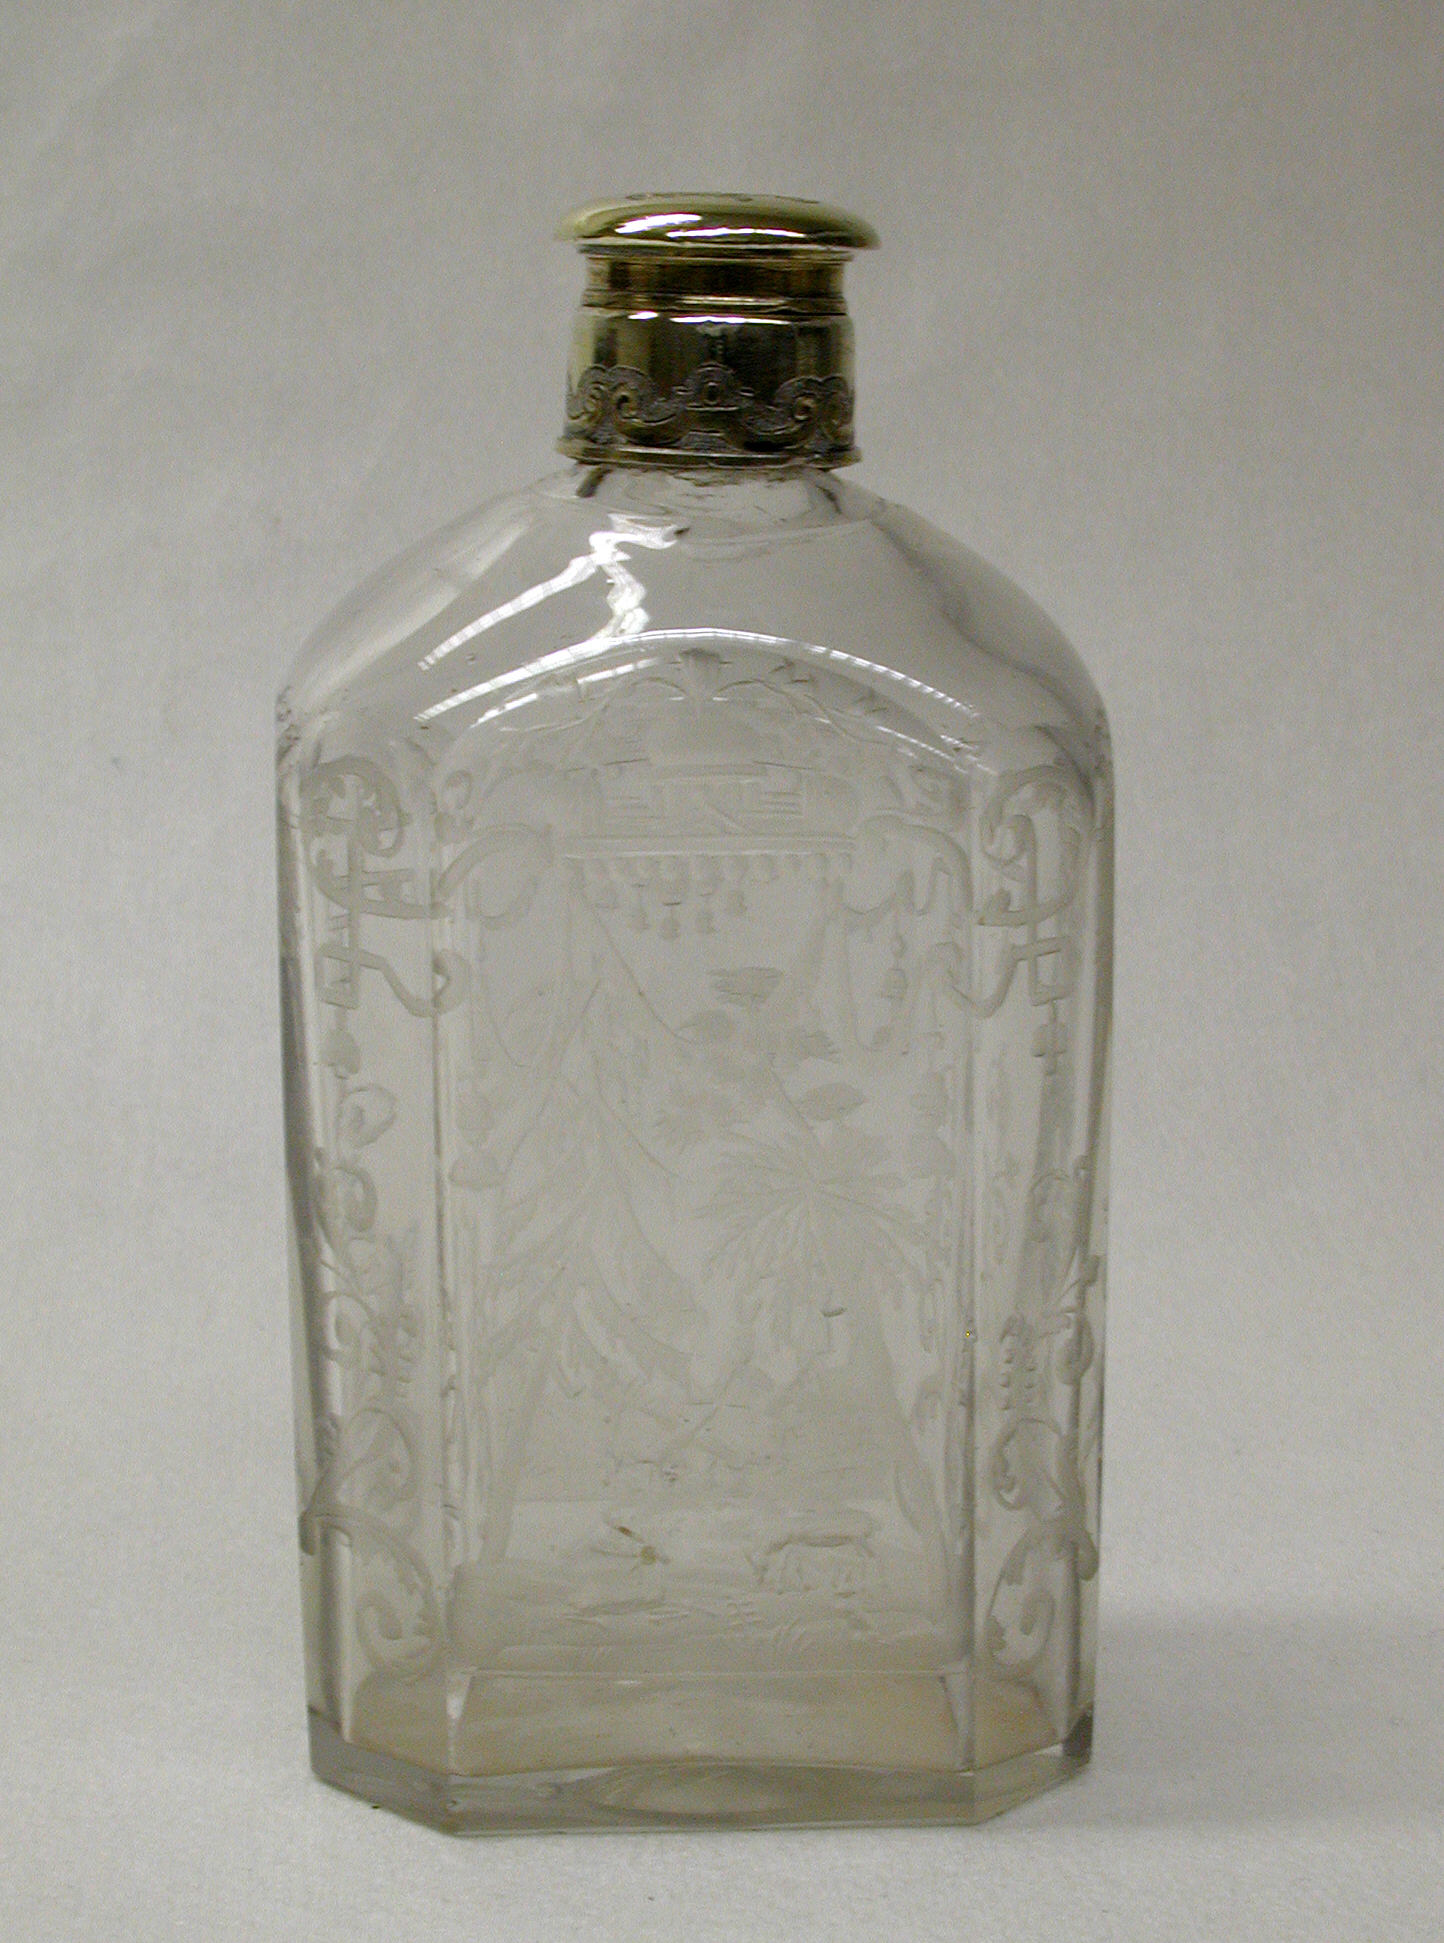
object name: flask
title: Flask (one of a pair)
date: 1701-1800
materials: glass, silver gilt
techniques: cutting